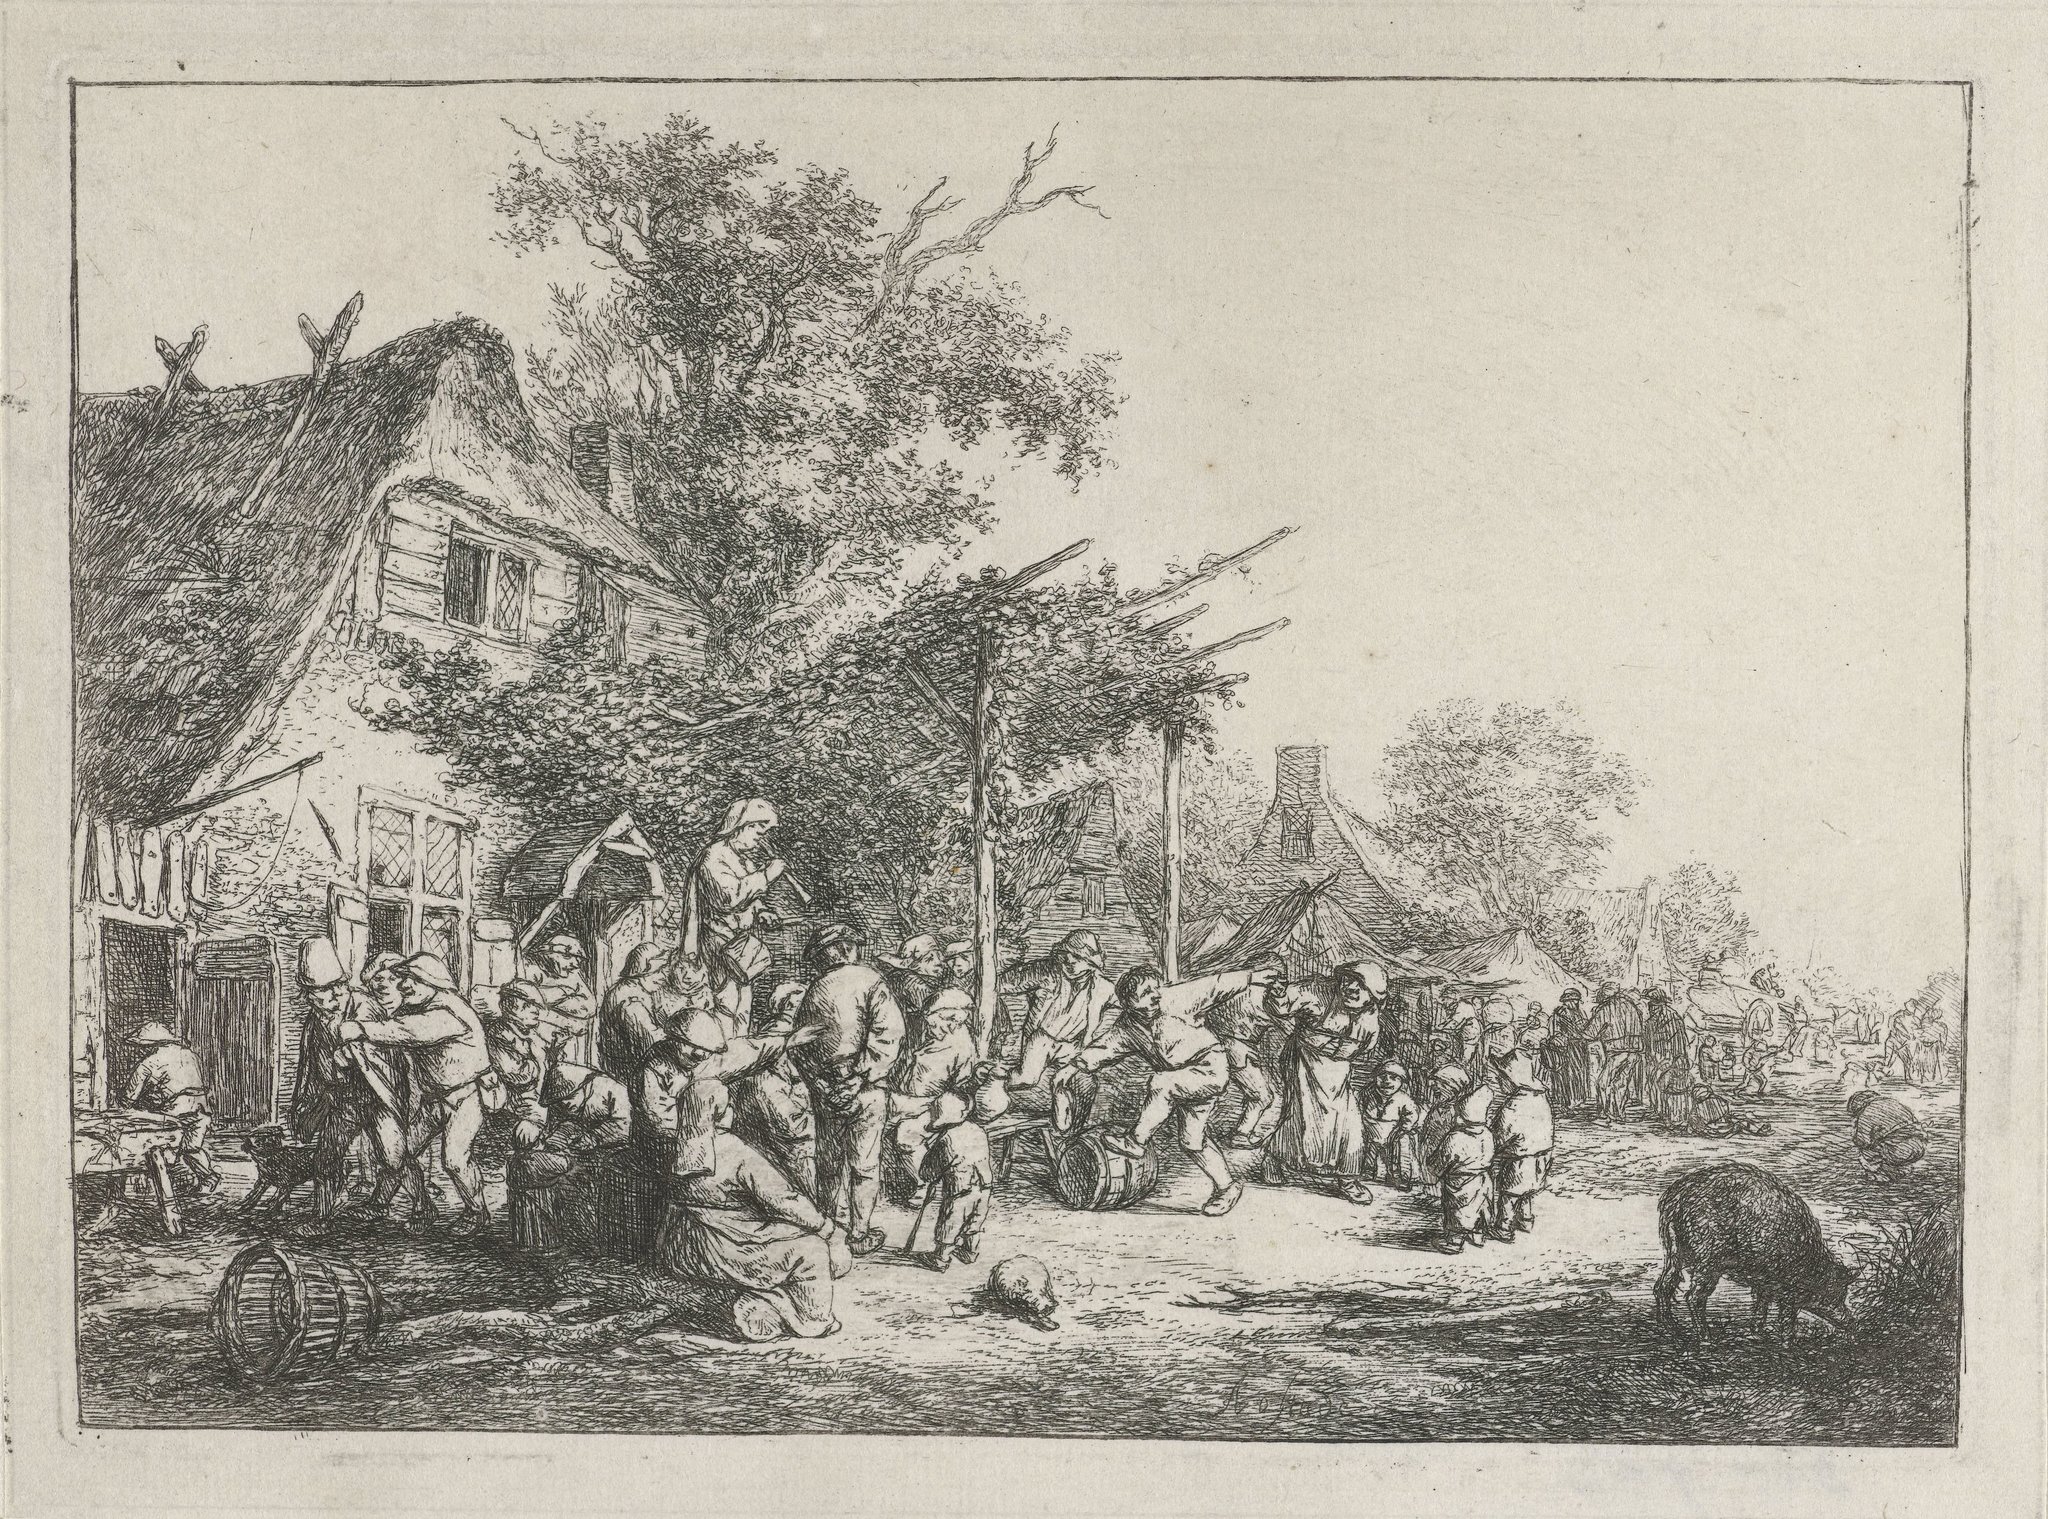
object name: print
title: Dansende boeren voor een herberg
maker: adriaen van ostade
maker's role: draughtsman, painter, print maker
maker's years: 1610-1685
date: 1651-1655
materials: paper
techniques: etching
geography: haarlem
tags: one pair dancing; man and woman dancing as a couple, public festivities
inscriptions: collector's mark: Lugt 240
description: In een dorpsstraat wordt feest gevierd waarbij het er vrolijk aan toegaat. Een groot aantal dorpsbewoners kijkt geanimeerd toe hoe een man en vrouw dansen op de muziek van een muzikant.